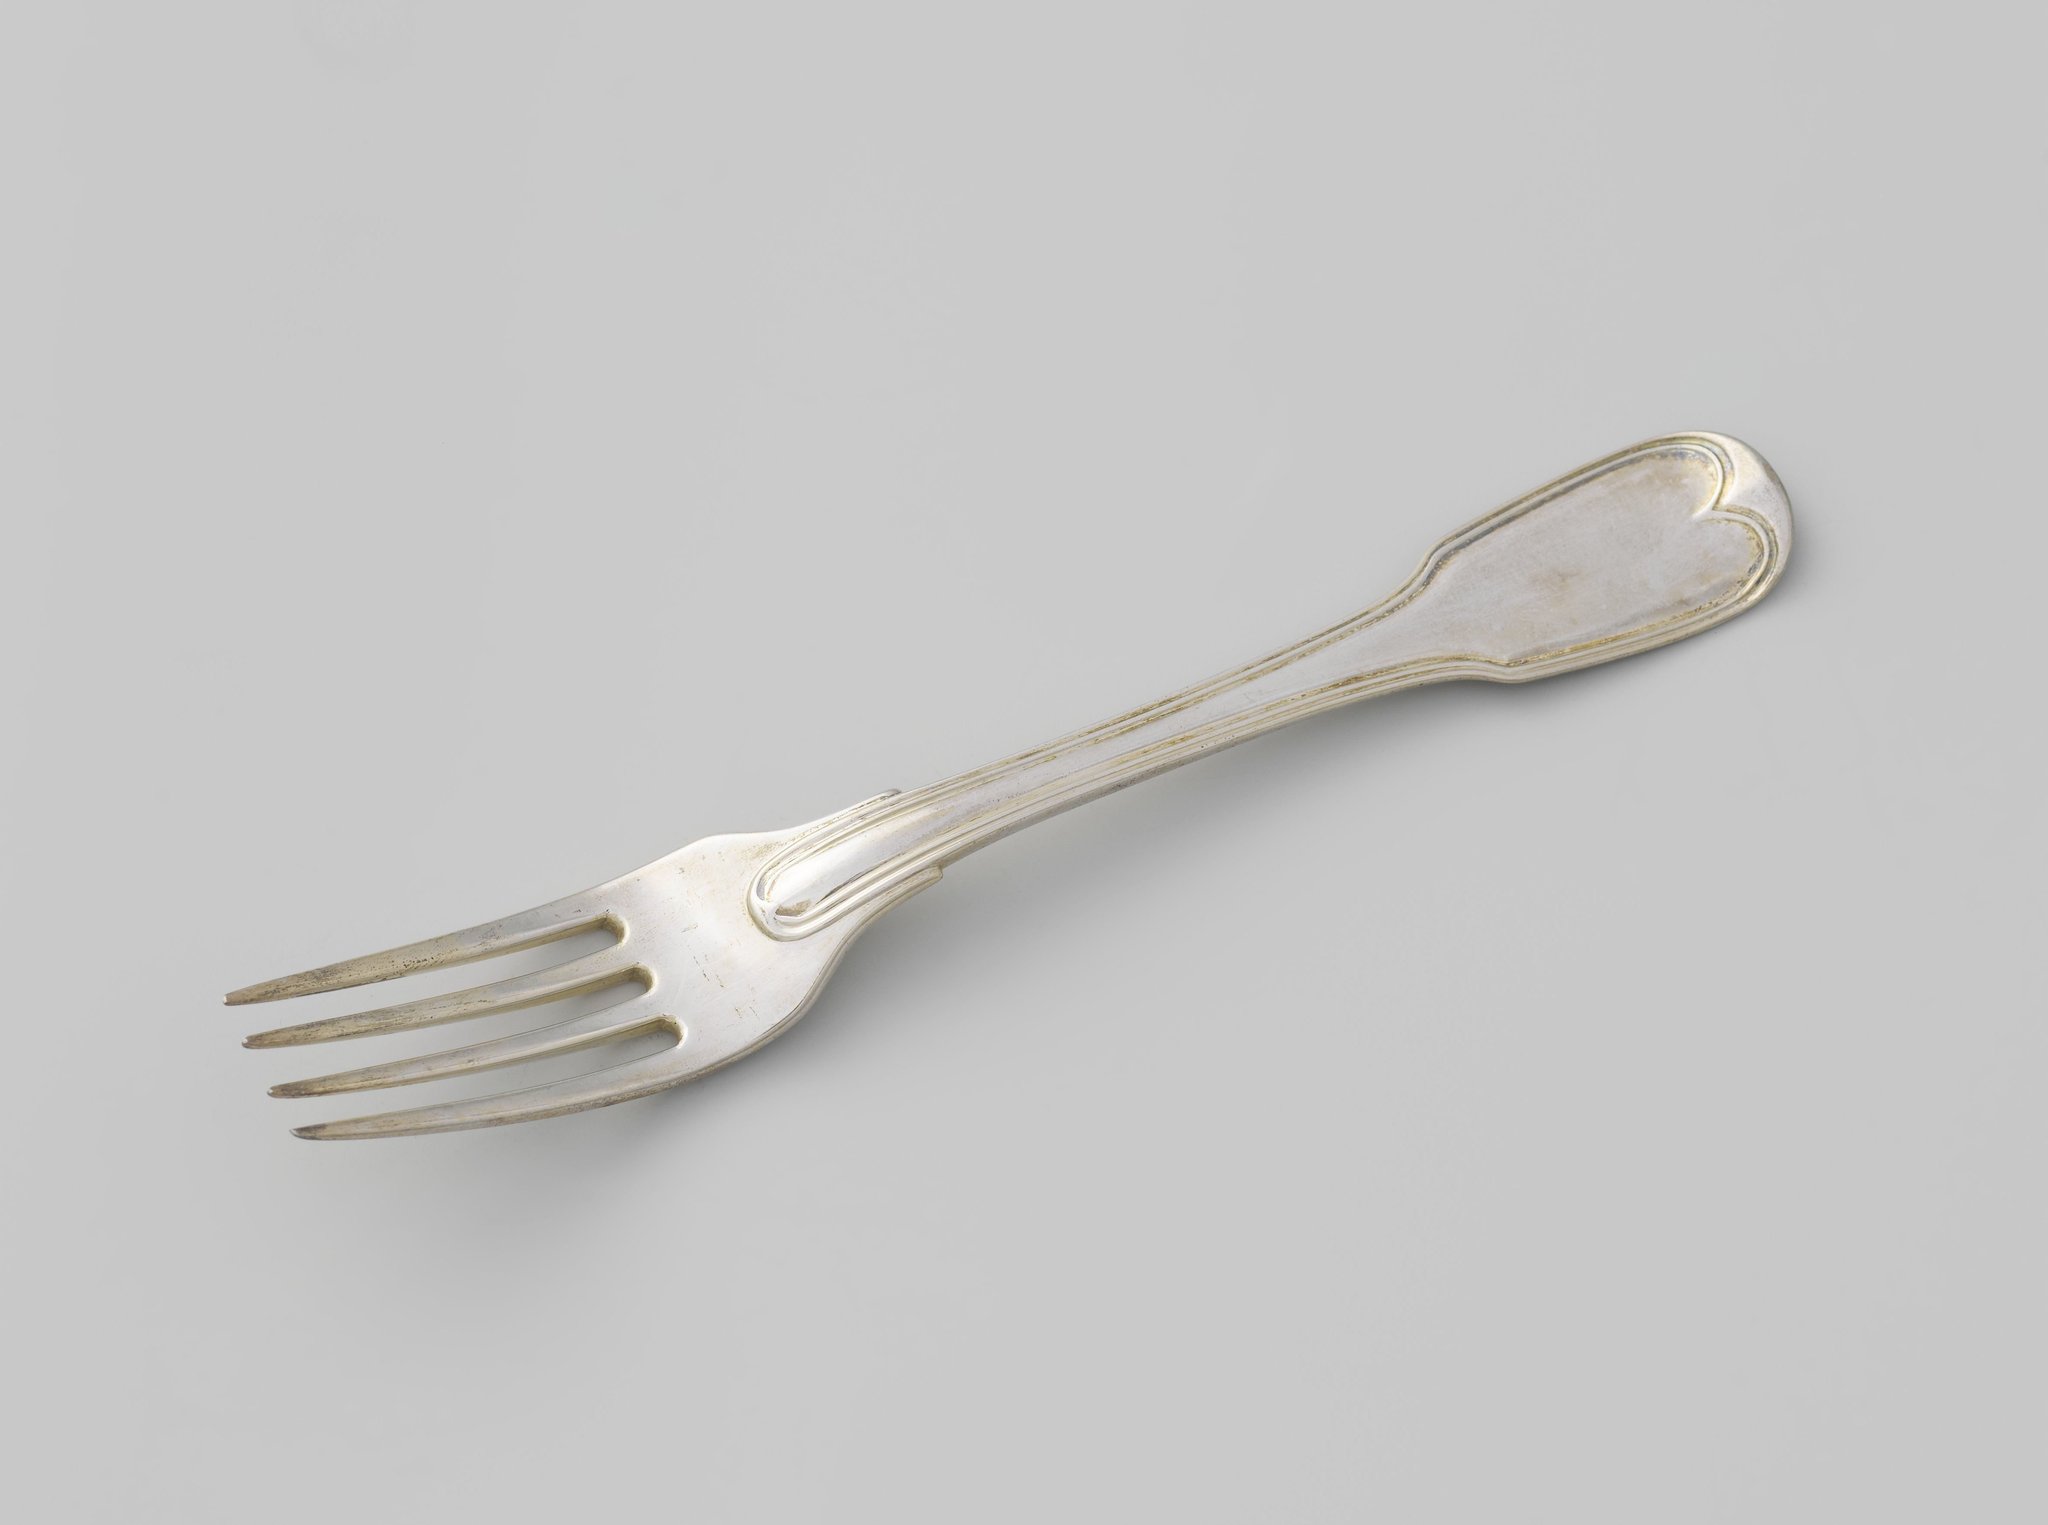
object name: fork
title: Vork met het helmteken Clifford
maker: hendrik helweg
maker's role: silversmith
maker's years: 1802-1858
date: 1832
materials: silver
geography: amsterdam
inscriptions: alloy mark: ‘leeuw 1ste gehalte’, hallmark: ‘Minervakop met A (keurkamer Amsterdam)’, maker's mark: ‘HH onder anker in vierkant’, date letter: ‘X (=1806)’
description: De viertandige vork is aan zowel boven- als onderzijde door middel van enkel lof verbonden met de platte, gebogen steel, die zich verbreedt naar het spatelvormige uiteinde. Boven- en onderzijde van de steel worden omgeven door een dubbele filetrand, die bij het uiteinde ingezwenkt is. Op de onderzijde van de spatel is het helmteken Clifford gegraveerd.